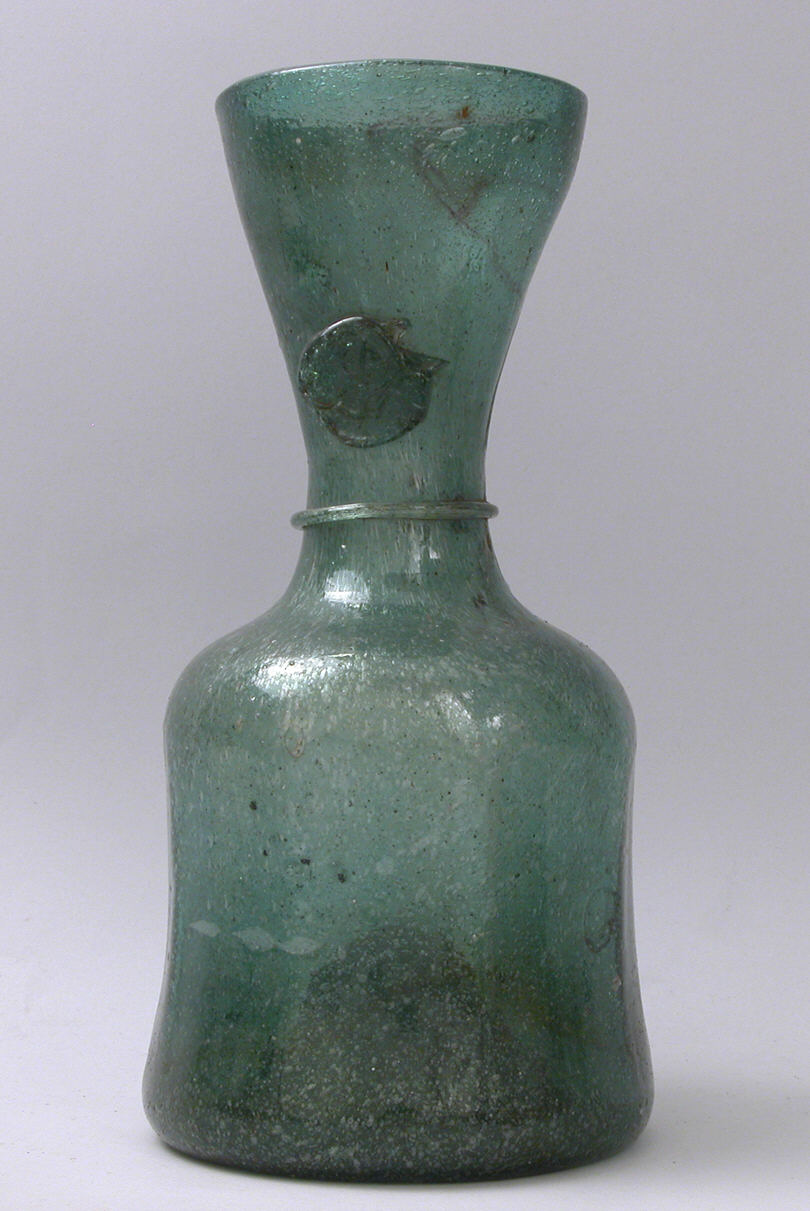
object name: bottle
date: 1801-1900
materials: glass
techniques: glassblowing, tooling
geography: north africa